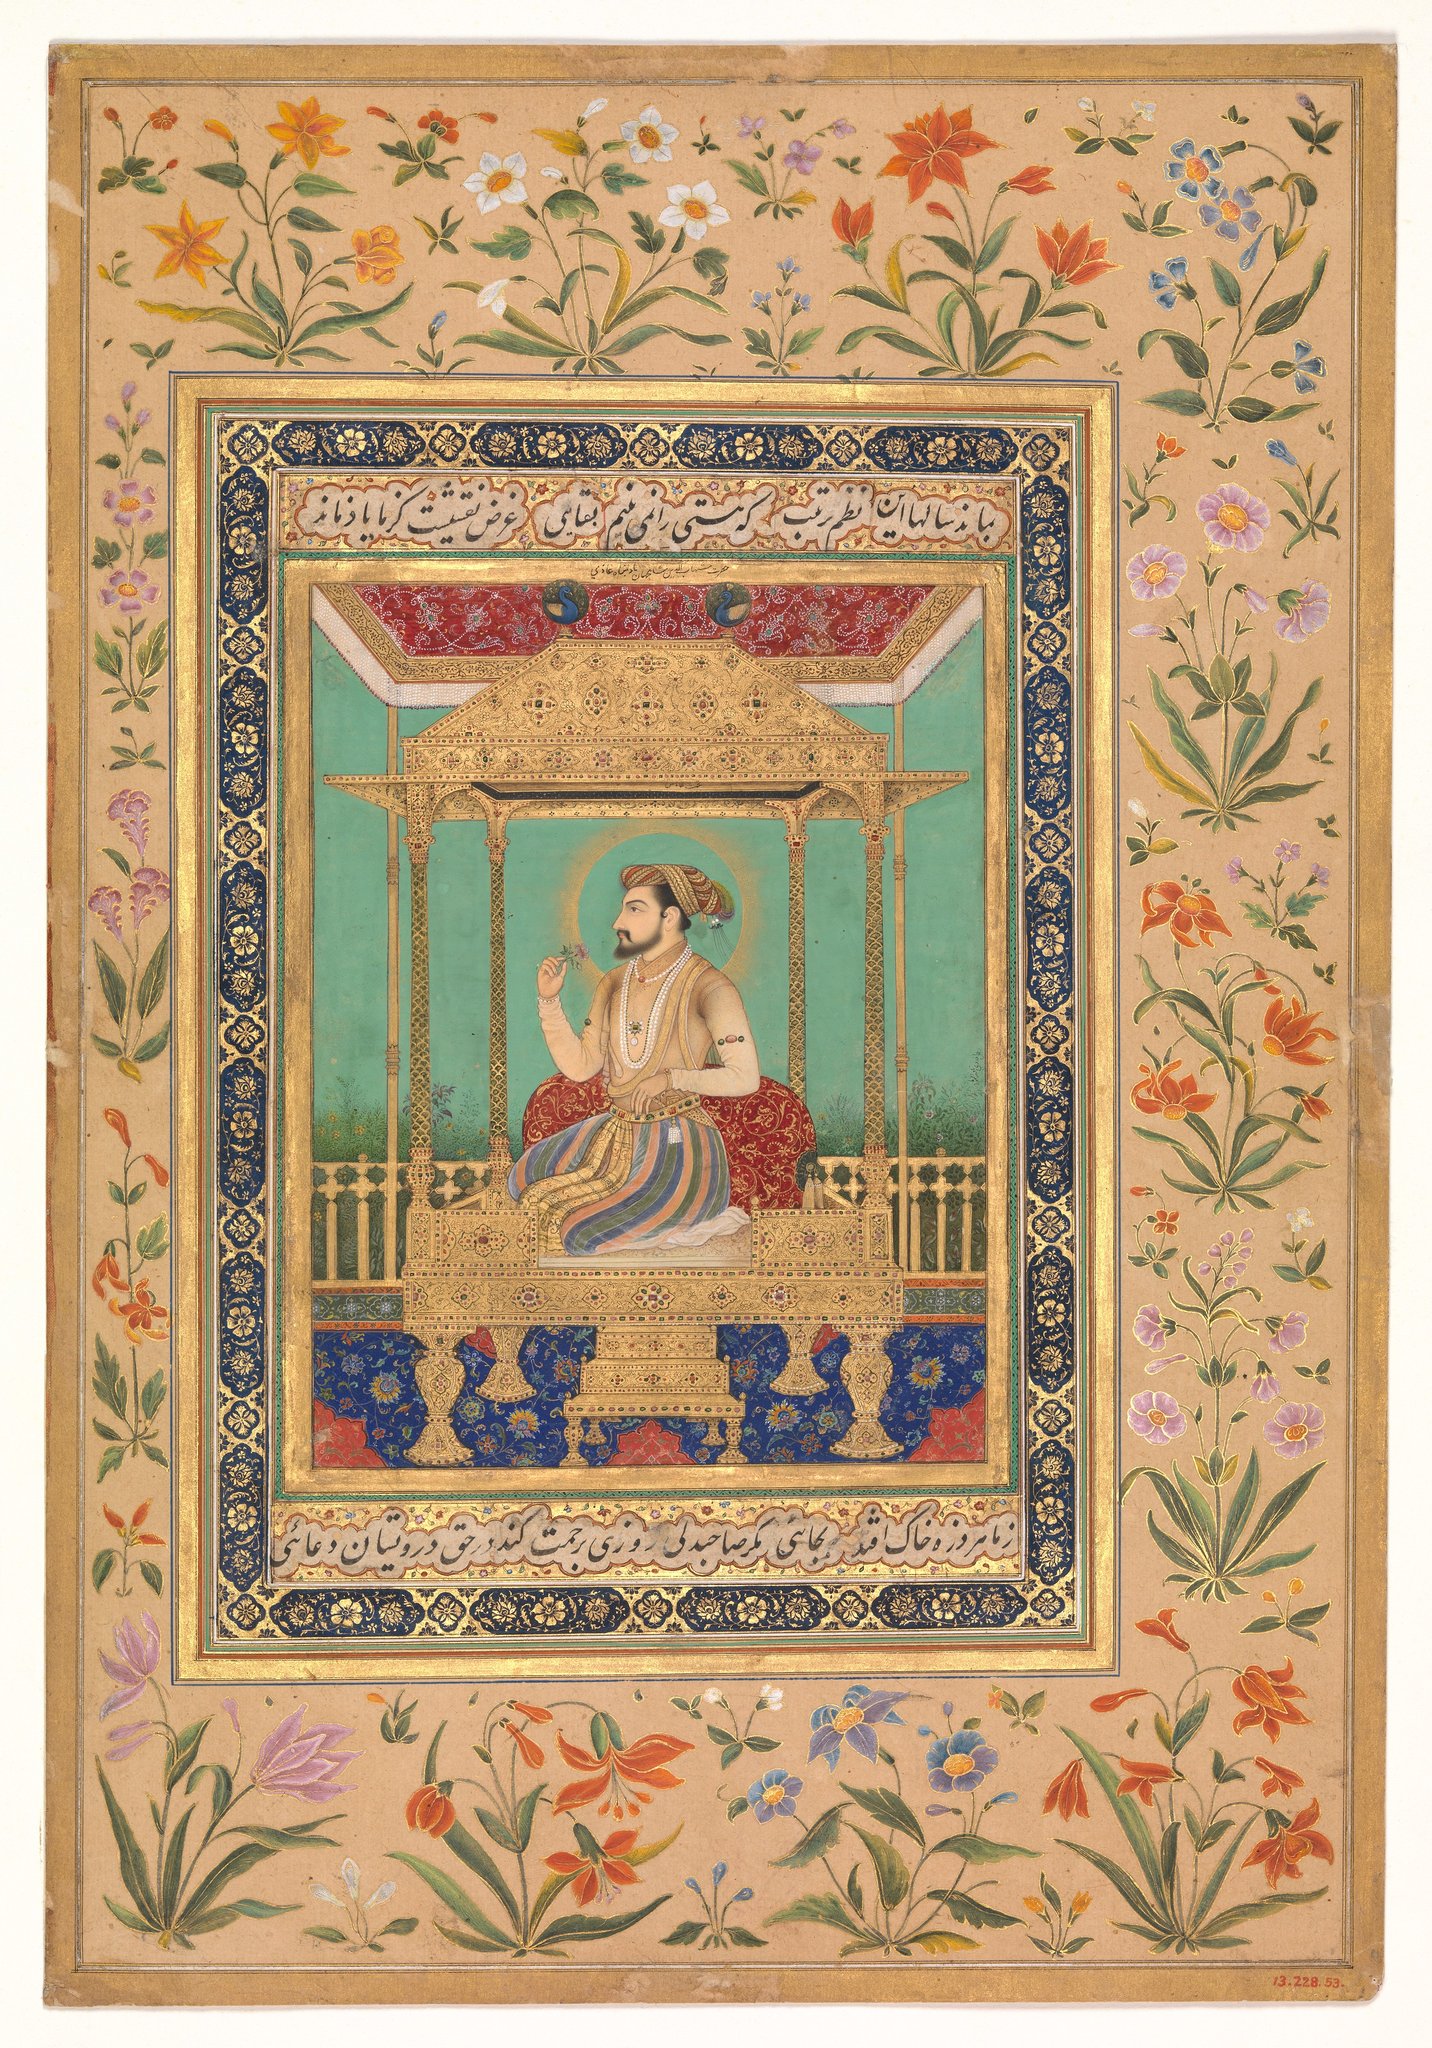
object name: album leaf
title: Portrait of Shah Jahan on the Peacock Throne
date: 1801-1900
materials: gold, ink, paper, watercolor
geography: india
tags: men,flowers